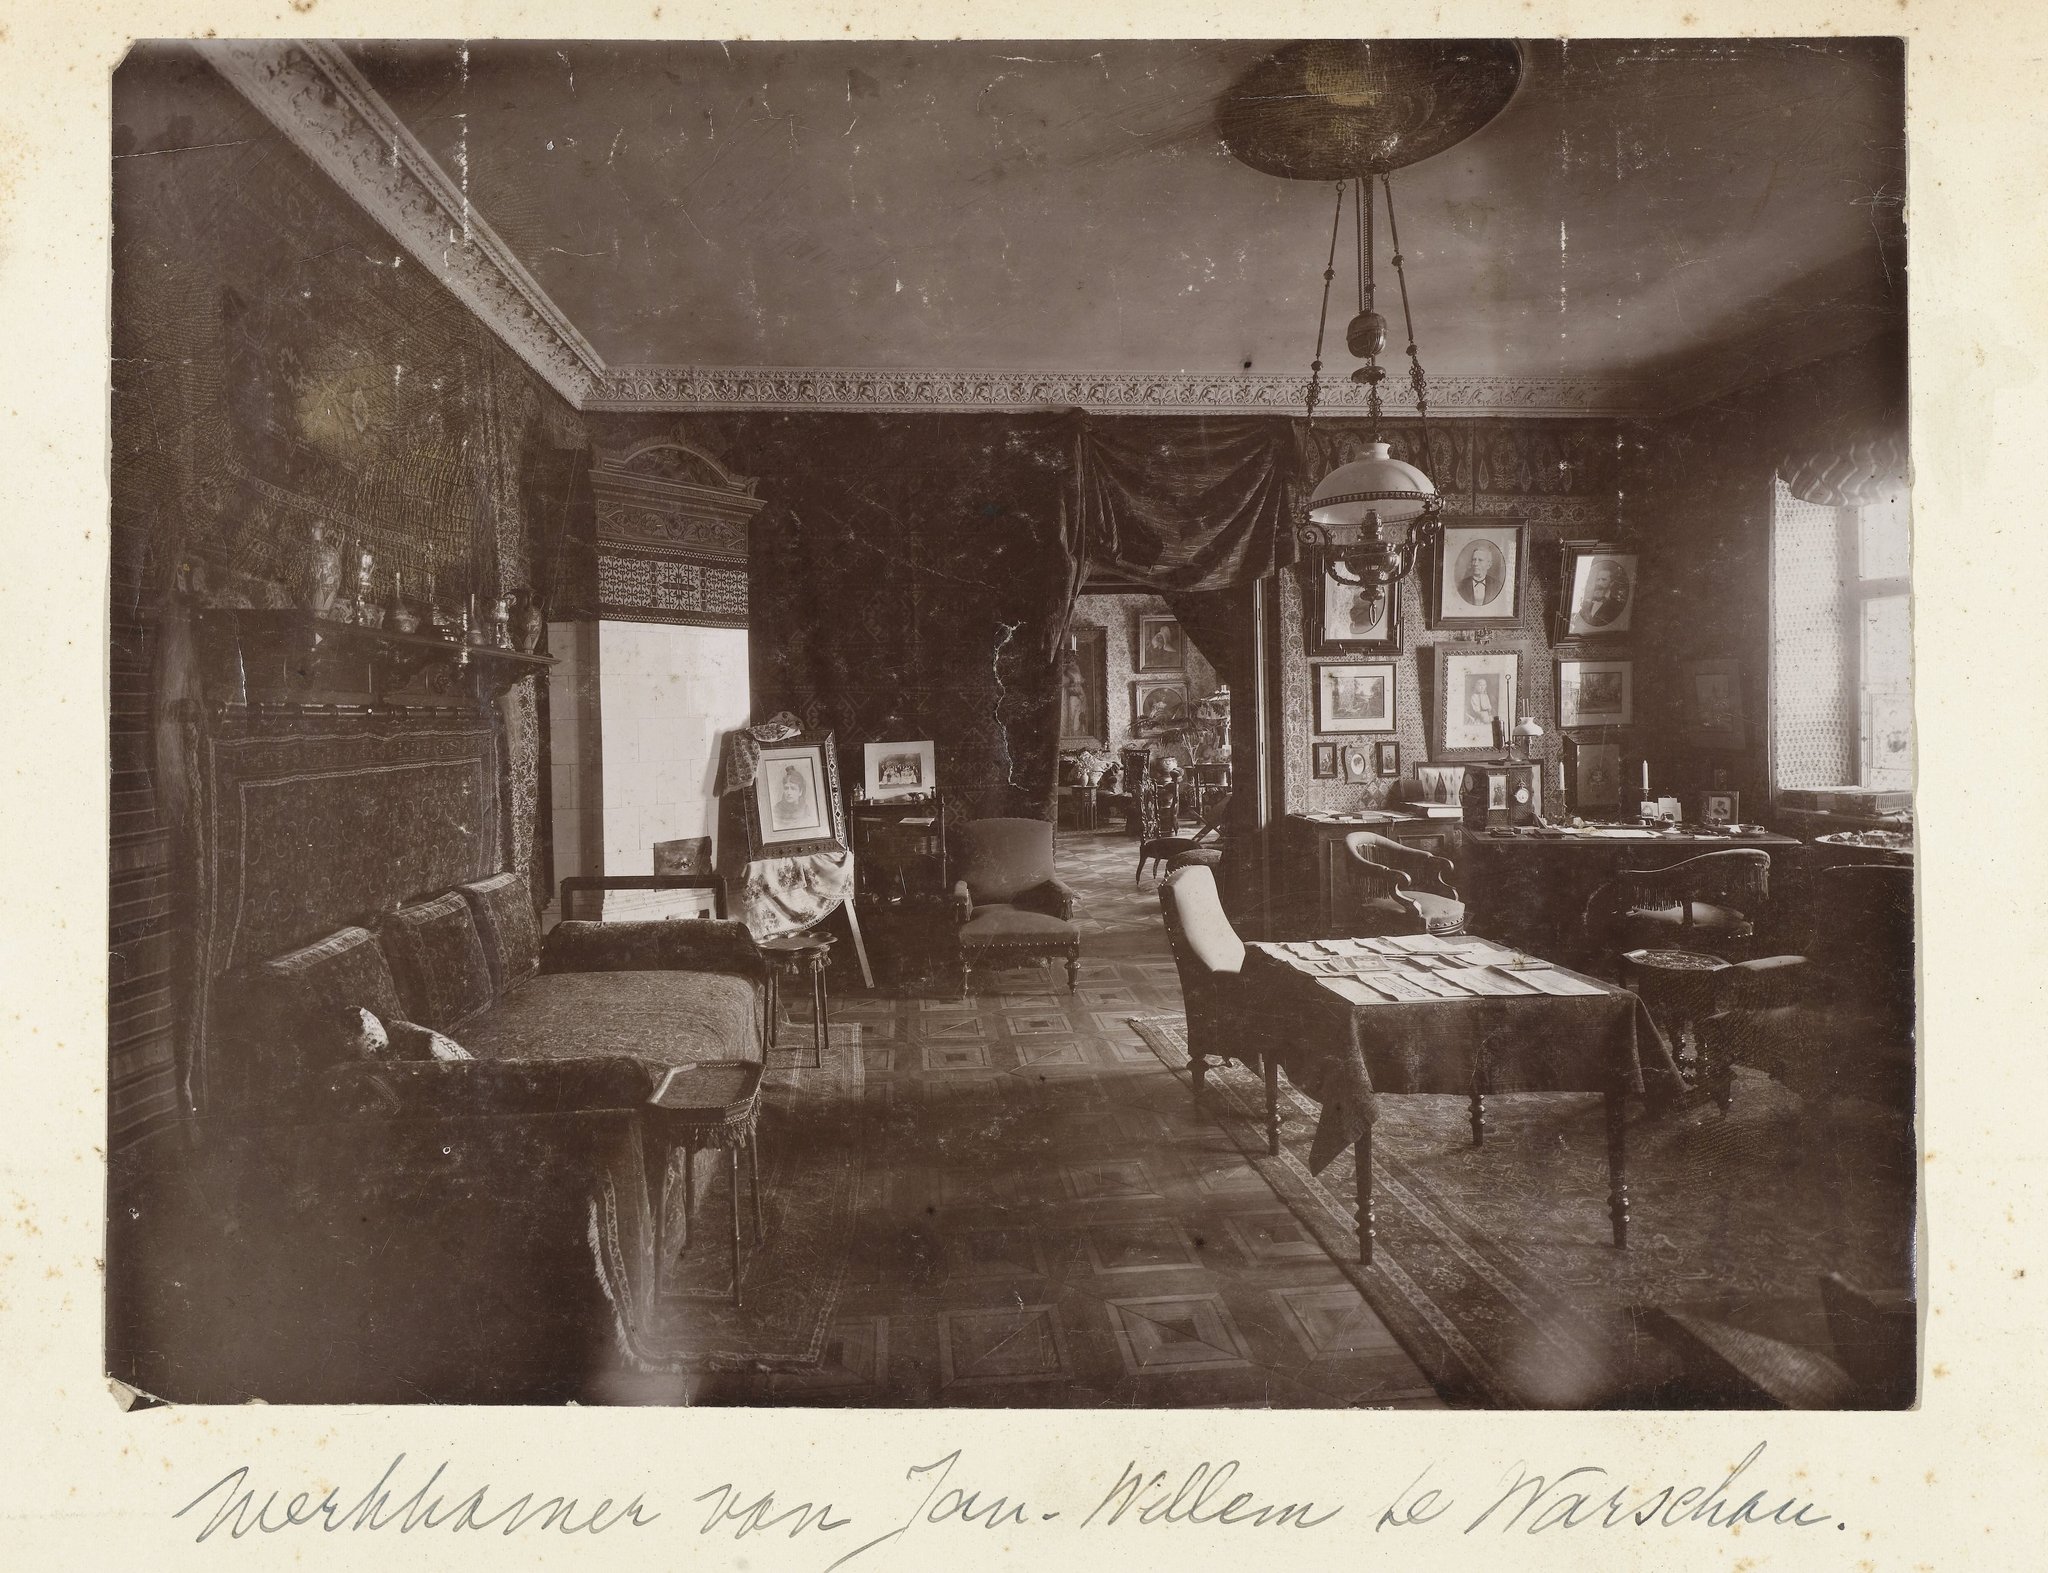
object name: photograph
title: Werkkamer van Jan Willenm te Warschau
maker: Anonymous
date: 1890-1910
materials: cardboard, paper, photographic support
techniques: gelatin silver print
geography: indonesia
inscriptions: caption: ‘5 kiekjes te Djattie roenggo’